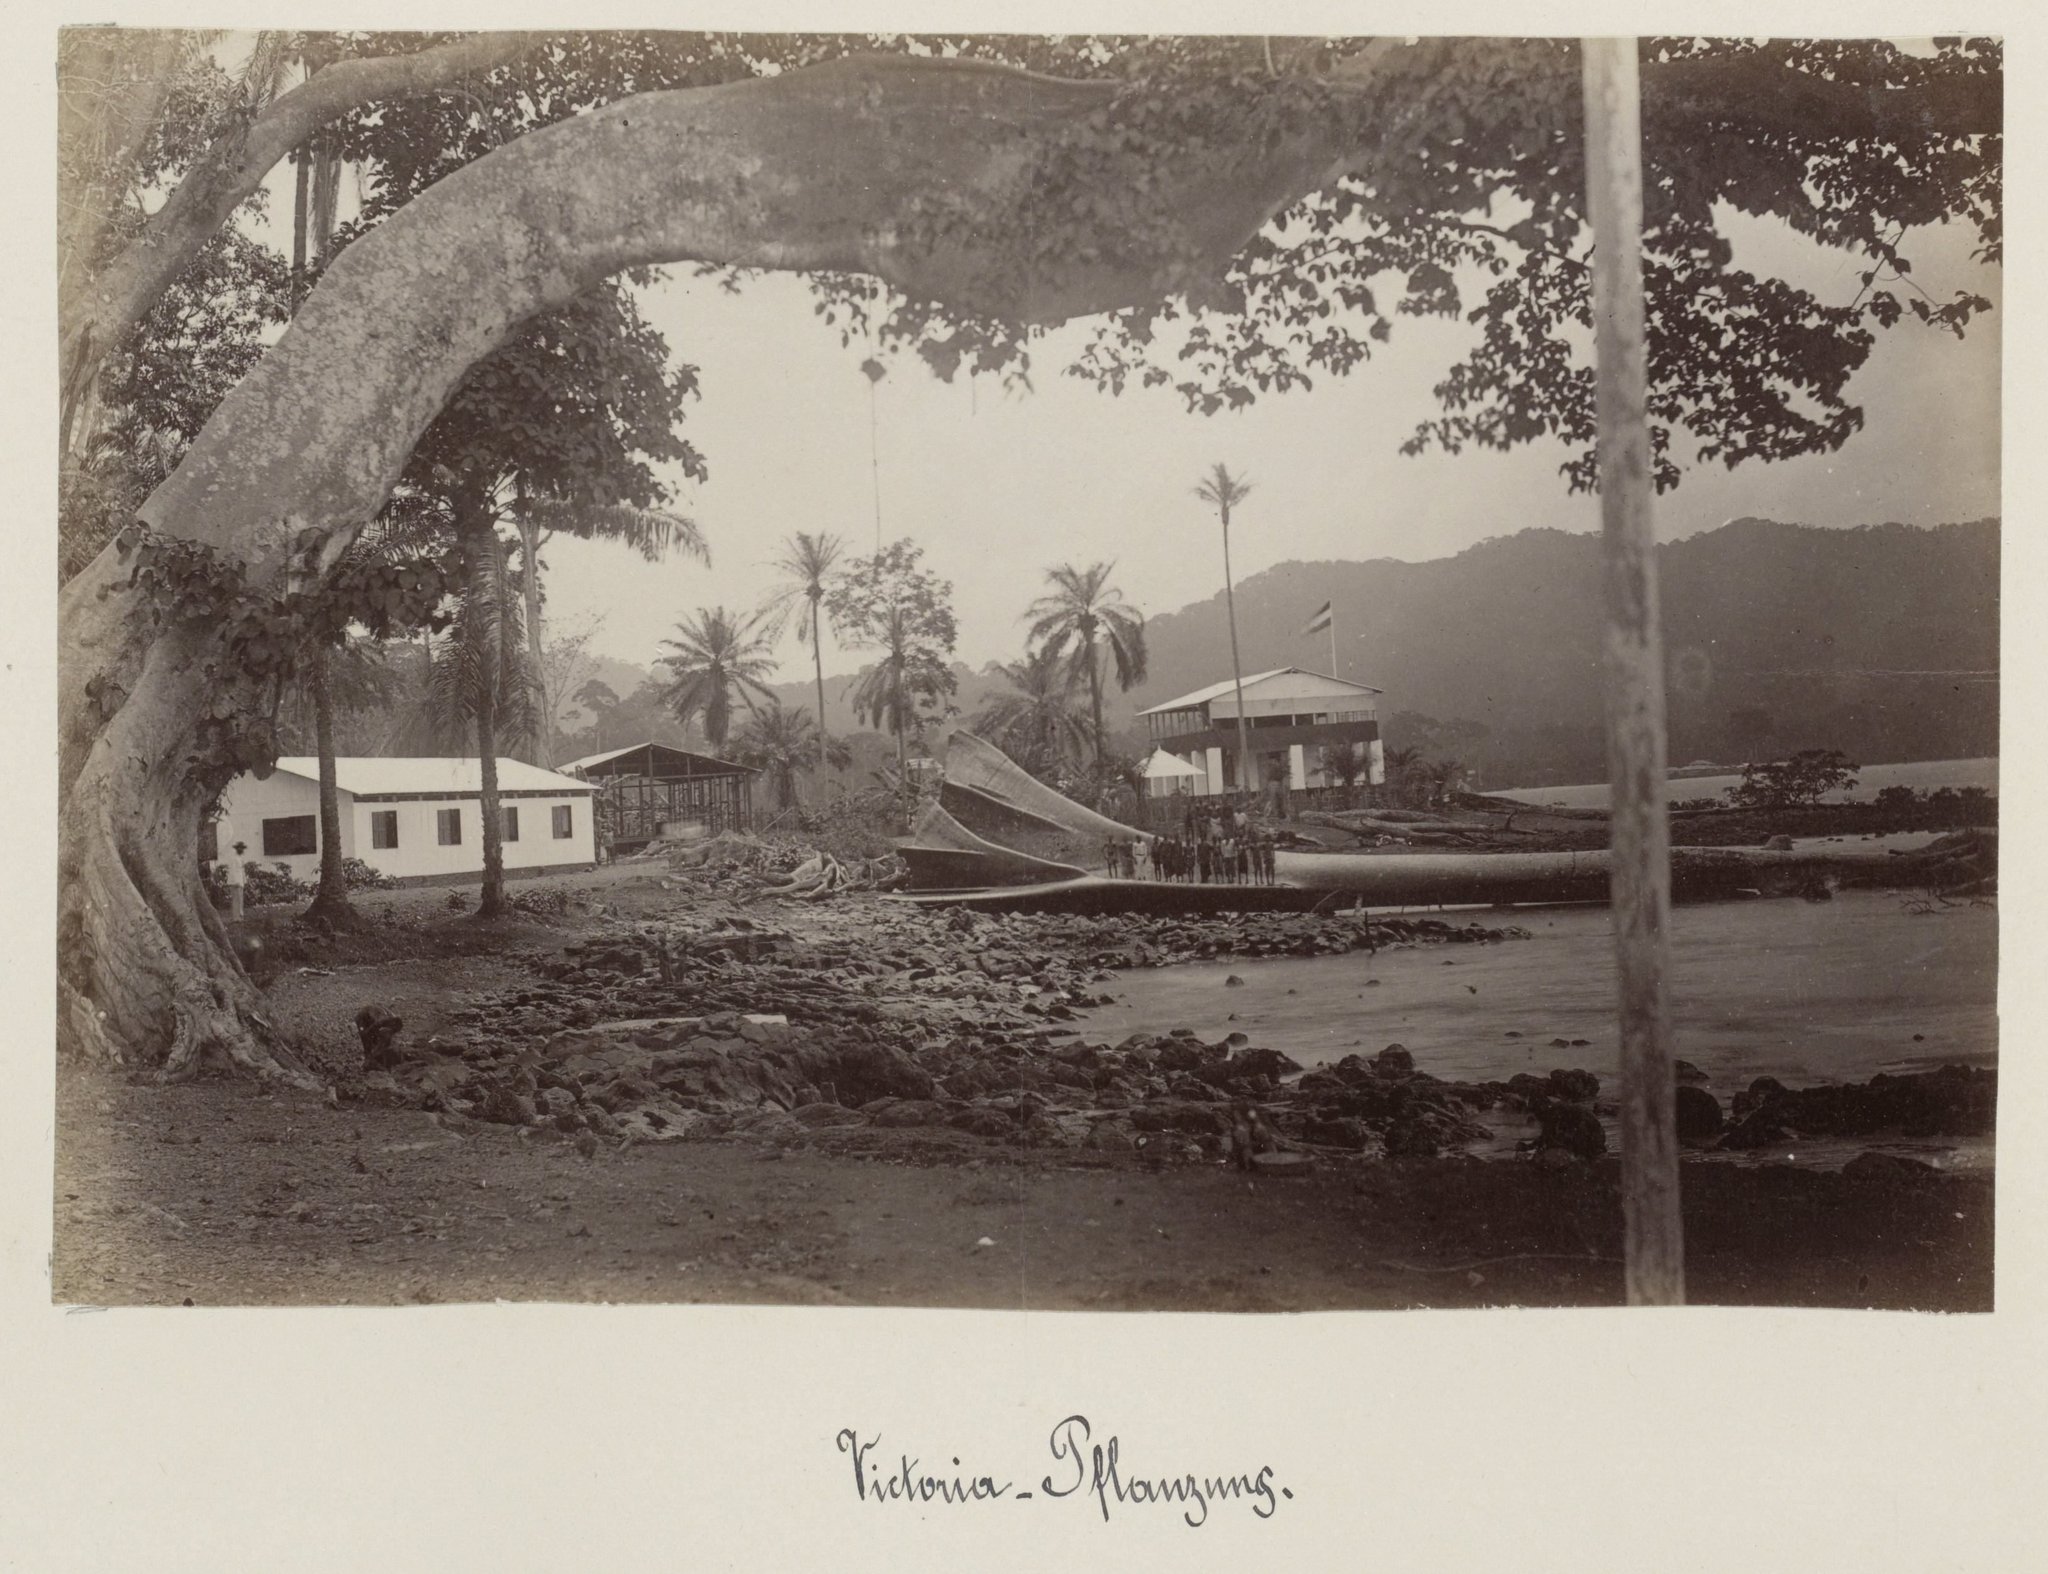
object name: photograph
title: Plantage met gekapte bomen aan een baai in Victoria (Kameroen)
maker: Anonymous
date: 1899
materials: photographic support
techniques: albumen print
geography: victoria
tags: plantation, gulf, bay (+ landscape with figures, staffage), trees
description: Onderdeel van Fotoalbum met opnames van Kameroen rond 1899.